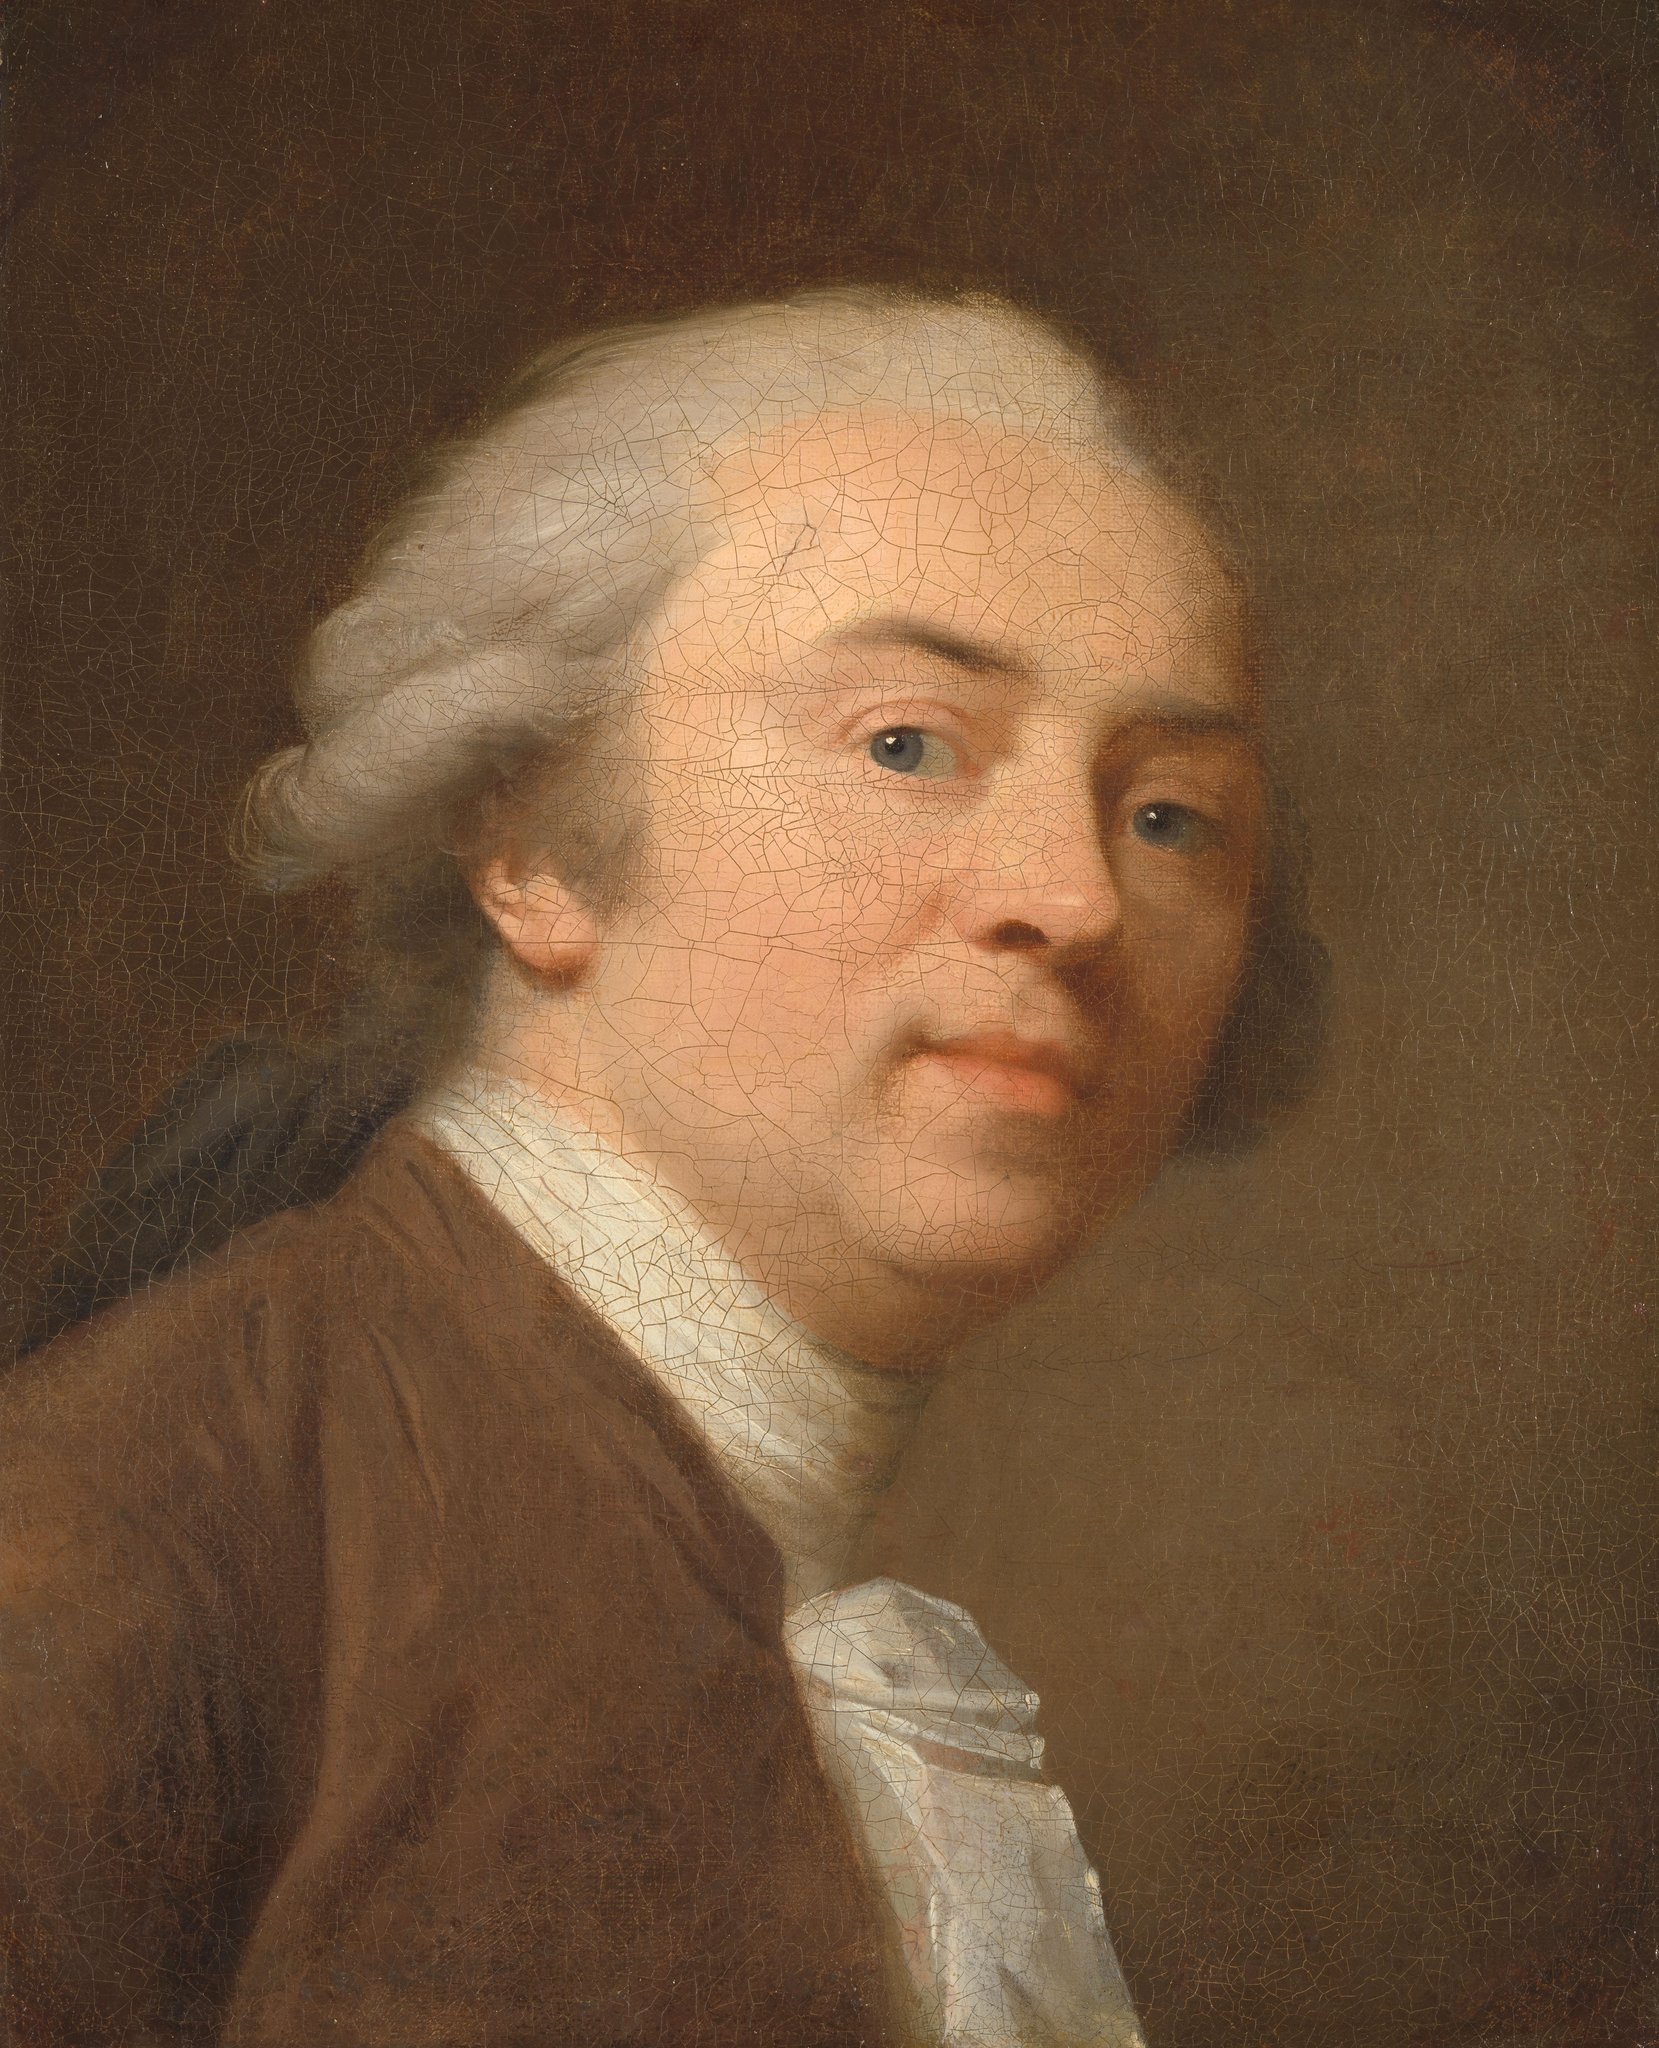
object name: painting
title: Self-Portrait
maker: johann friedrich august tischbein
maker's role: painter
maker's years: 1750-1812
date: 1782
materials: canvas, oil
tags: maastricht, painter, johann friedrich august tischbein, portrait, self-portrait of painter, portrait, self-portrait of artist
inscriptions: signature and date: ‘Fr. Tischbein se ipse pinxit Ann. 1782’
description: Tischbein came from a German family of artists and was called the ‘Dutch Tischbein’. This was not only because he was born in Maastricht and spent his childhood in The Hague, but also because he portrayed the stadtholder’s family in the 1780s, as can be seen in this gallery. His elegant likenesses were universally admired.